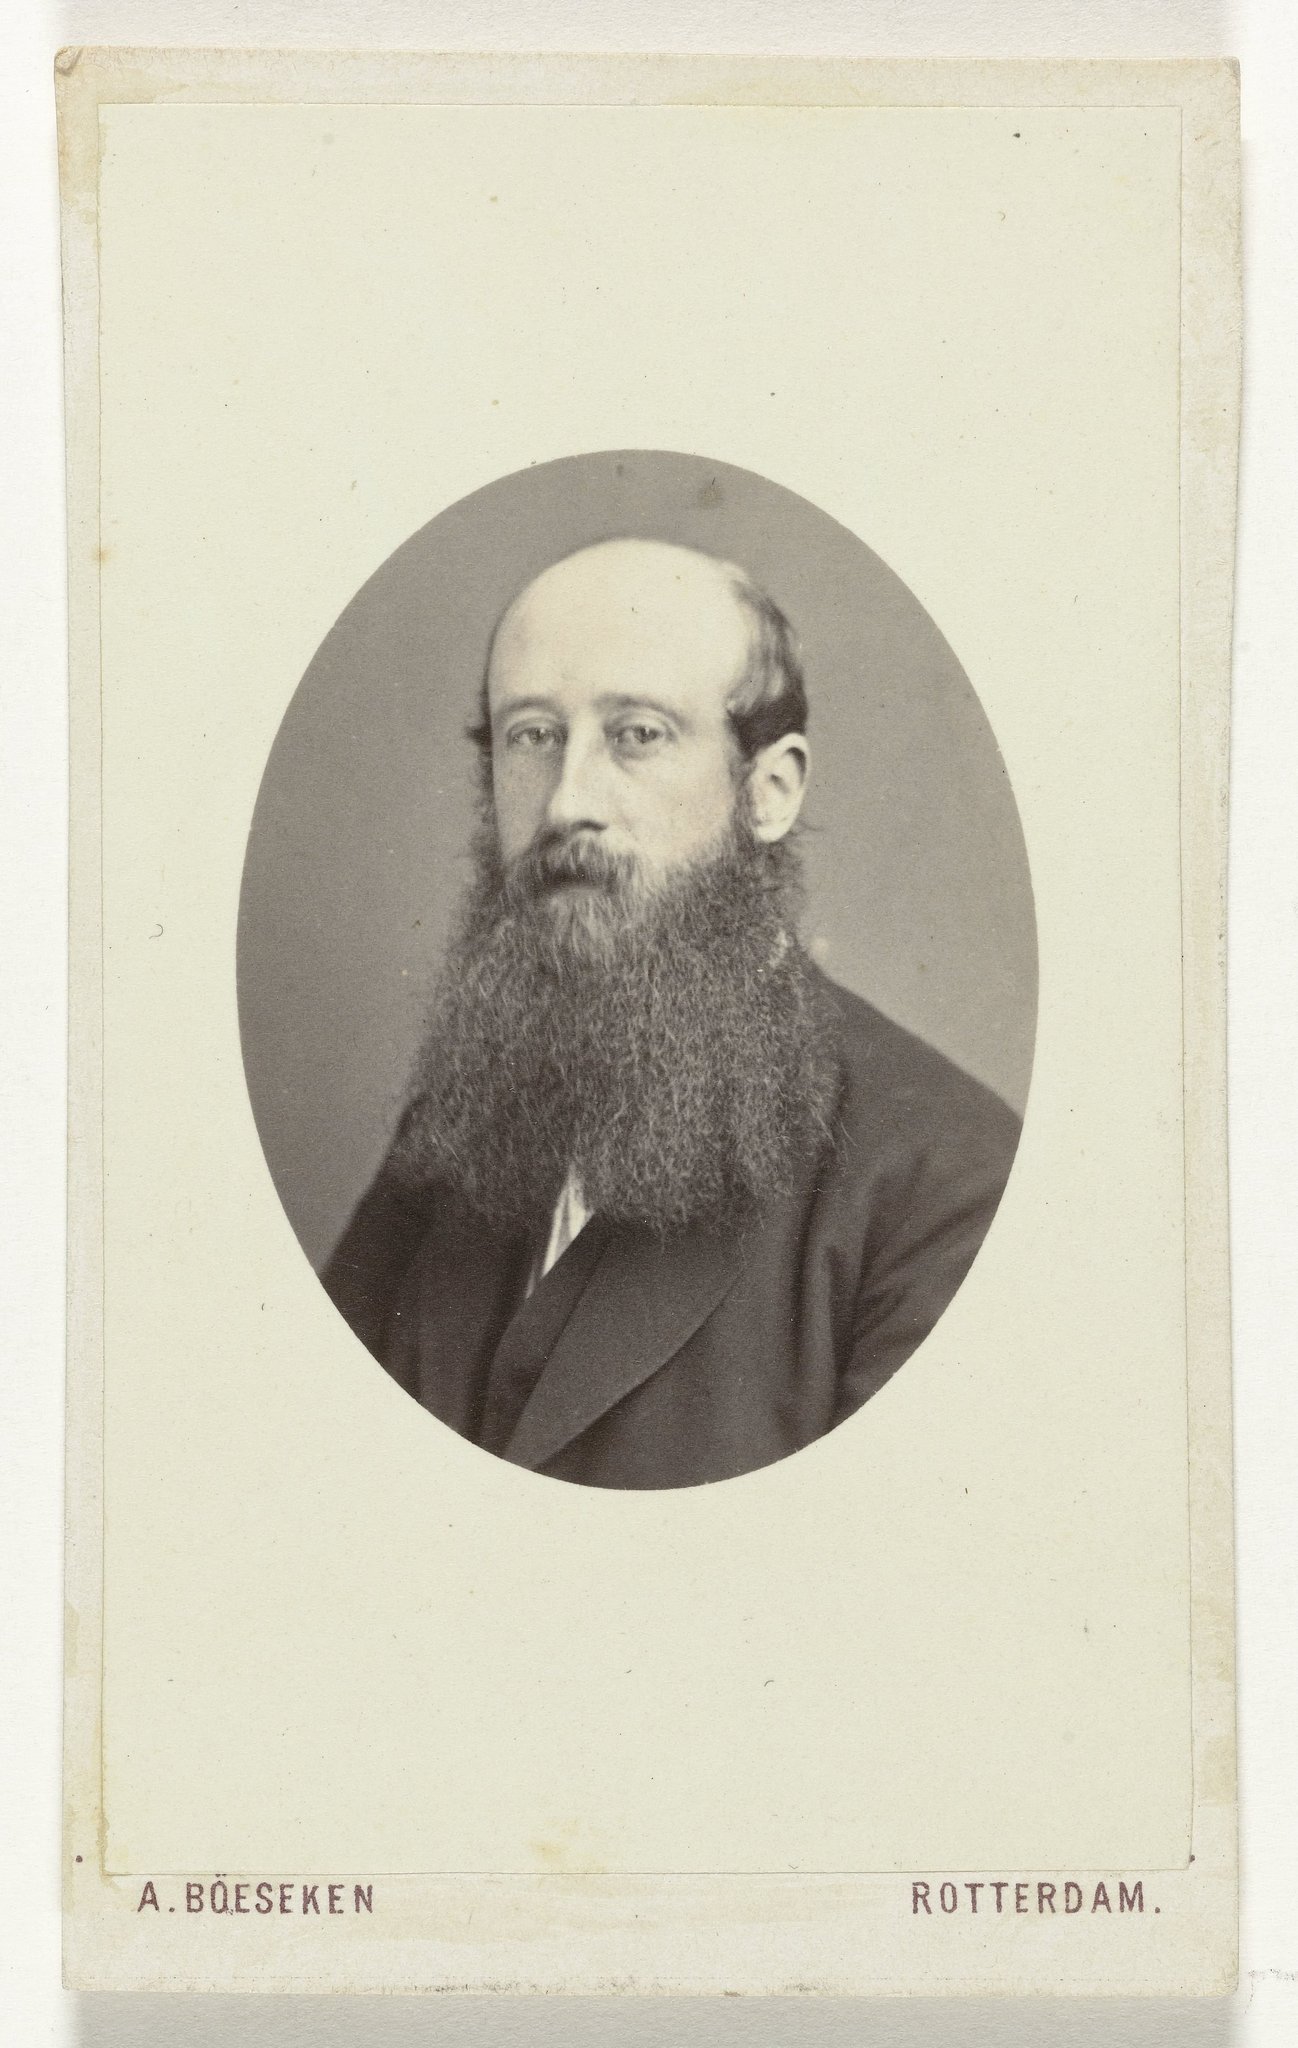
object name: carte de visite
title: Portret van makelaar J. N. van Houten Jr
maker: a. böeseken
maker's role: fotograaf, lithograaf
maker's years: 1834-1919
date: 1870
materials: cardboard, paper, photographic support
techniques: albumen print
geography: rotterdam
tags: makelaar, j.n. houten jr.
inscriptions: address: ‘A. Böeseken/Photographisch Atelier/Rotterdam/Hoogstraat over de/Vlasmarkt’, annotation: ‘J.N. van Houten Jr/Makelaar’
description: Kalende man met een lange baard, in ovaal, zonder achtergrond.